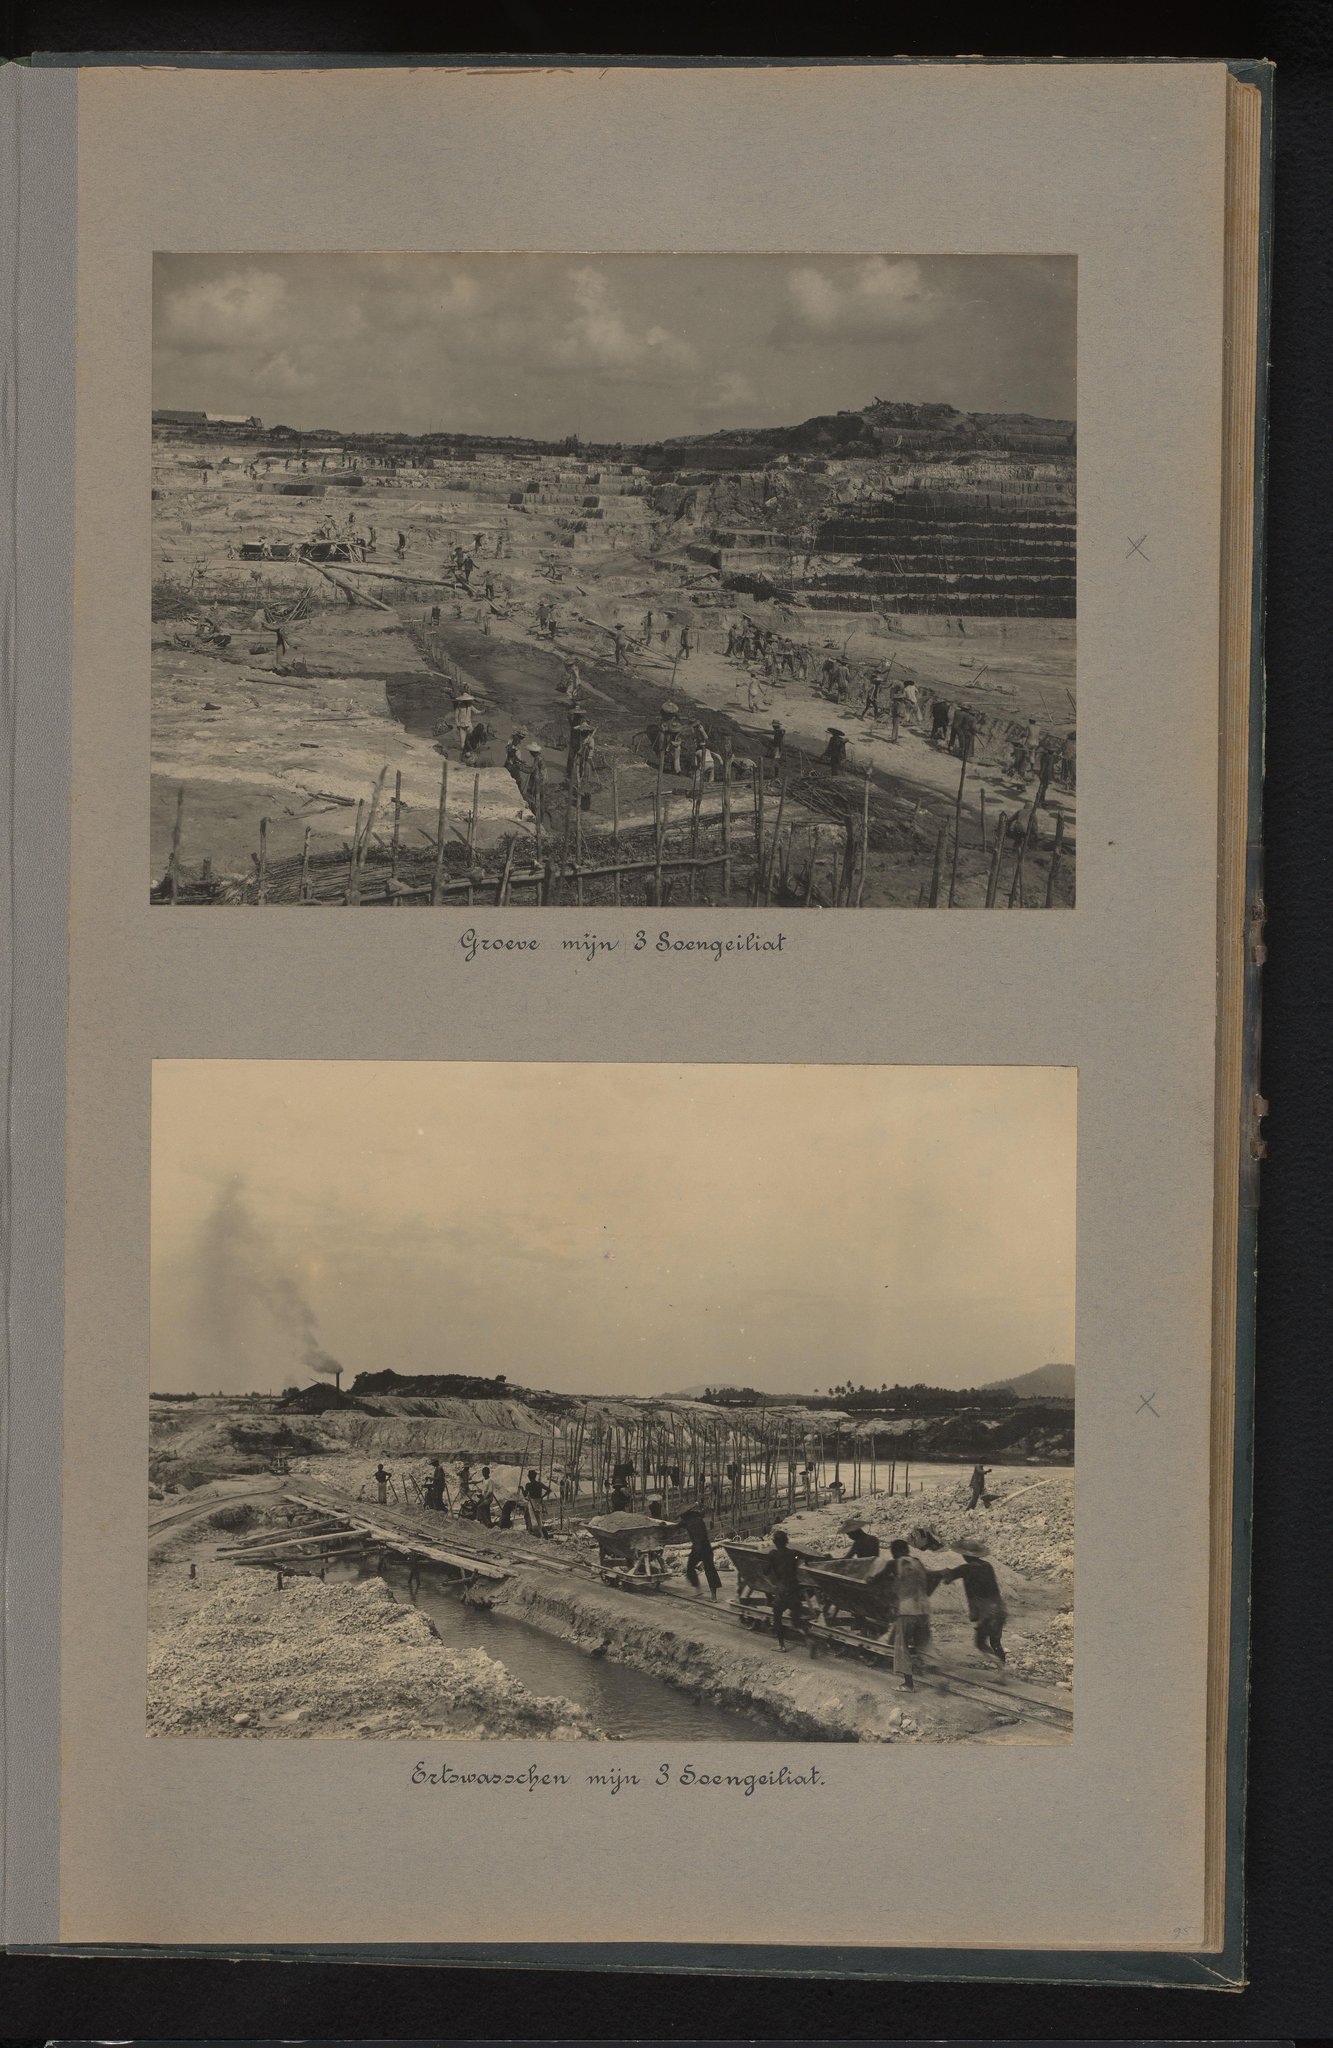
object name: photograph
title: Werkzaamheden in een mijn van de Banka-tinwinning te Soengeiliat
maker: Anonymous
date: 1914-1919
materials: cardboard, photographic support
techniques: gelatin silver print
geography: bangka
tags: robert julius boers, colonial system, opencast mine; strip mining, working class, labourers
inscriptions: inscription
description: Albumblad met 2 foto's van een arbeiders aan het werk in mijn 3 van de Banka-tinwinning te Soengeiliat. Onderdeel van het fotoalbum aangeboden aan Robert Julius Boers bij zijn vertrek naar Nederland in 1919 door het personeel van de Banka-tinwinning.